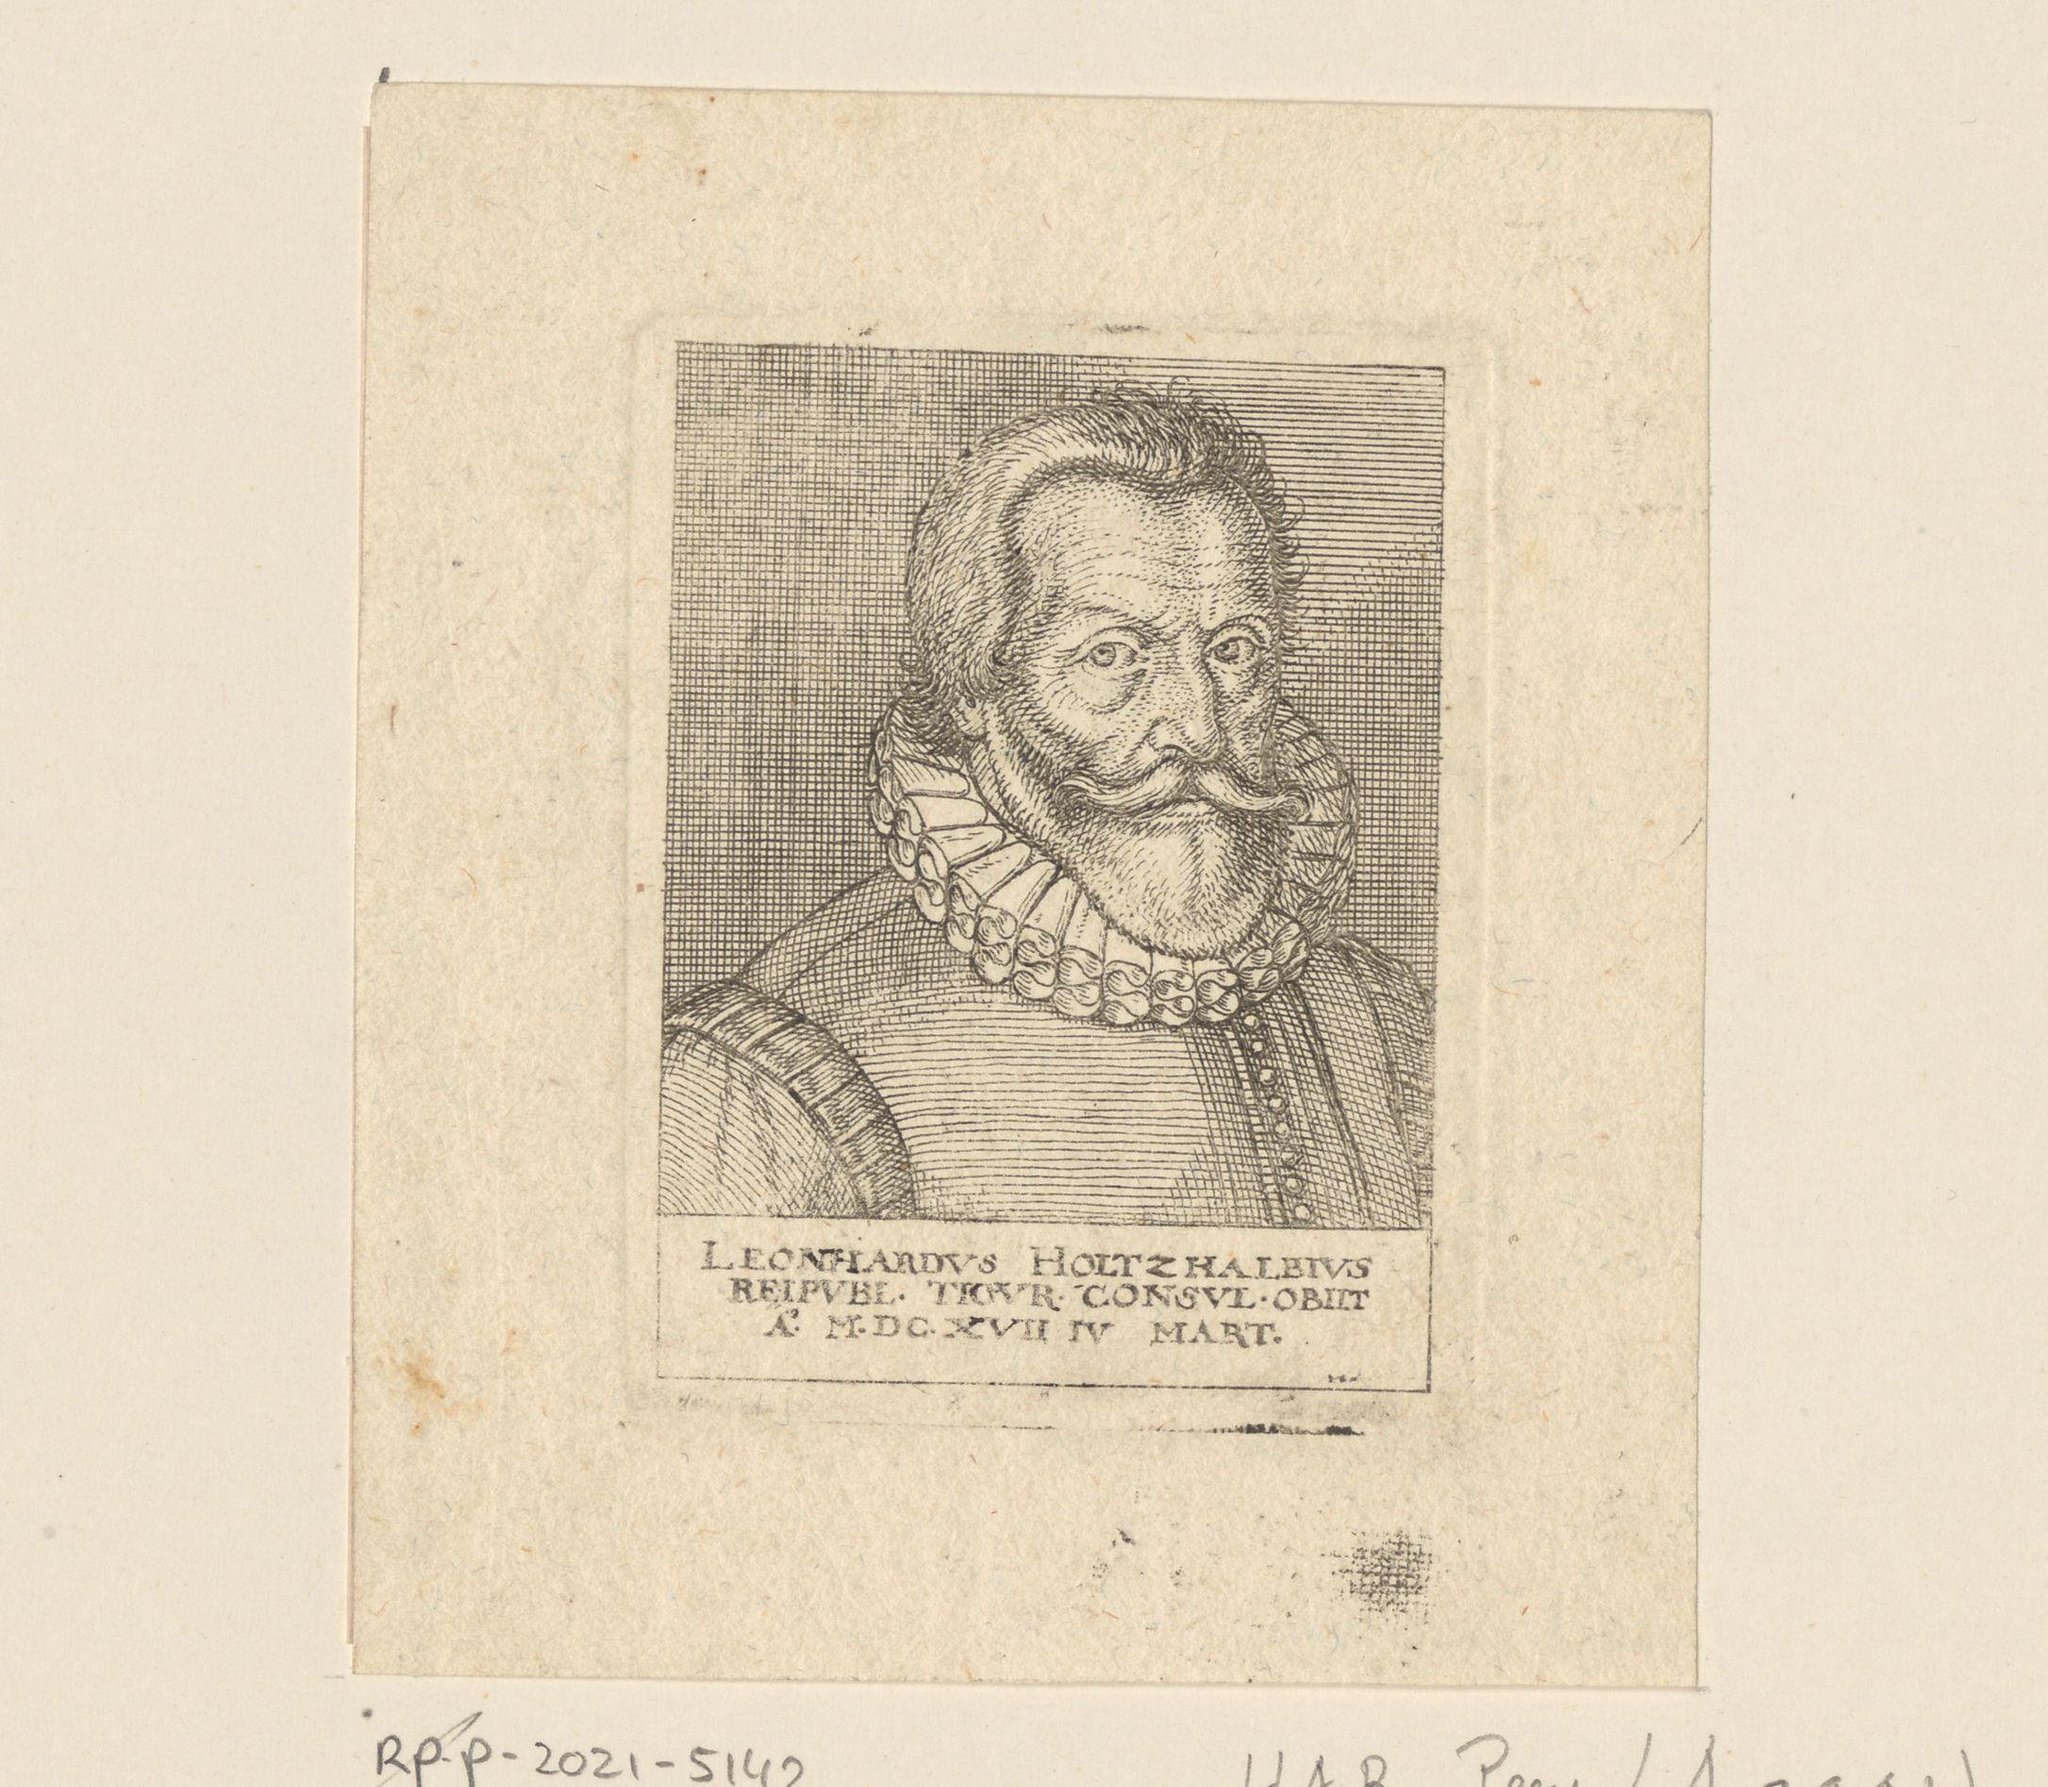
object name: print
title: Portret van Leonhard Holtzhalb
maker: Anonymous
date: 1617-1724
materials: paper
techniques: etching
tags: mayor, burgomaster, historical persons, beard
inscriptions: mark: ‘54’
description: Prent mogelijk gebruikt in: Appenzeller, Heinrich. Die von Konrad Meyer & Dietrich & Johannes Meyer in Kupfer gestochenen Bildnisse I: Bürgermeister, Antistes & Weltliche Herren. S.l.s.n., [1880-1912].